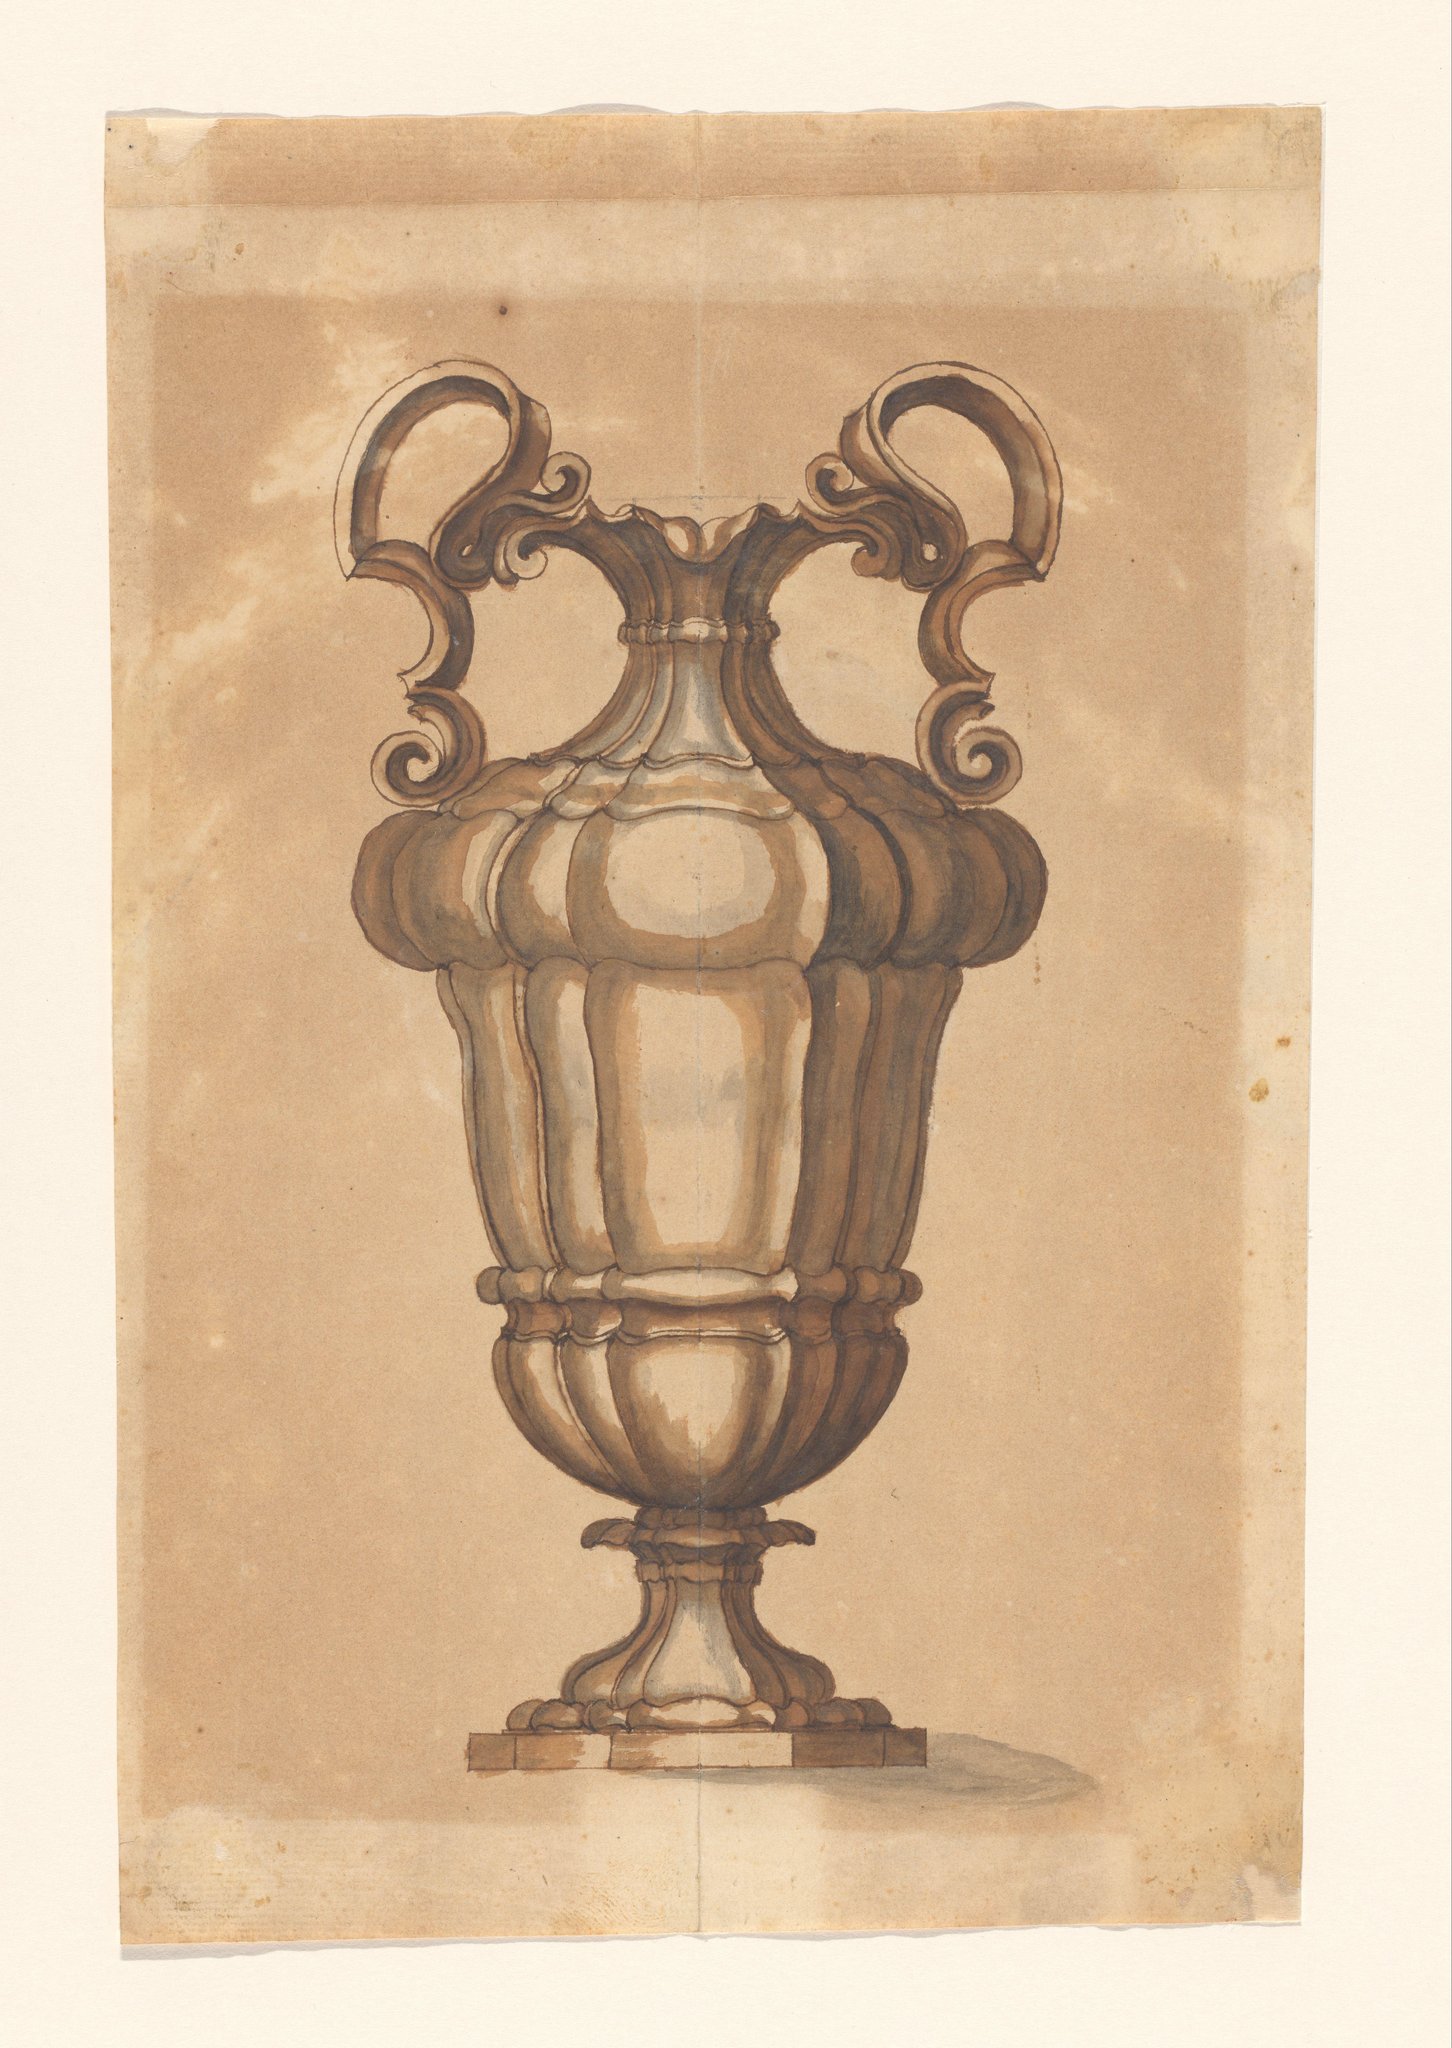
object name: design drawing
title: Vaas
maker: Anonymous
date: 1710-1725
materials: ink, paper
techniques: brush, pen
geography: italy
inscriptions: watermark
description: Ontwerp voor een koperkleurige vaas met twee oren.